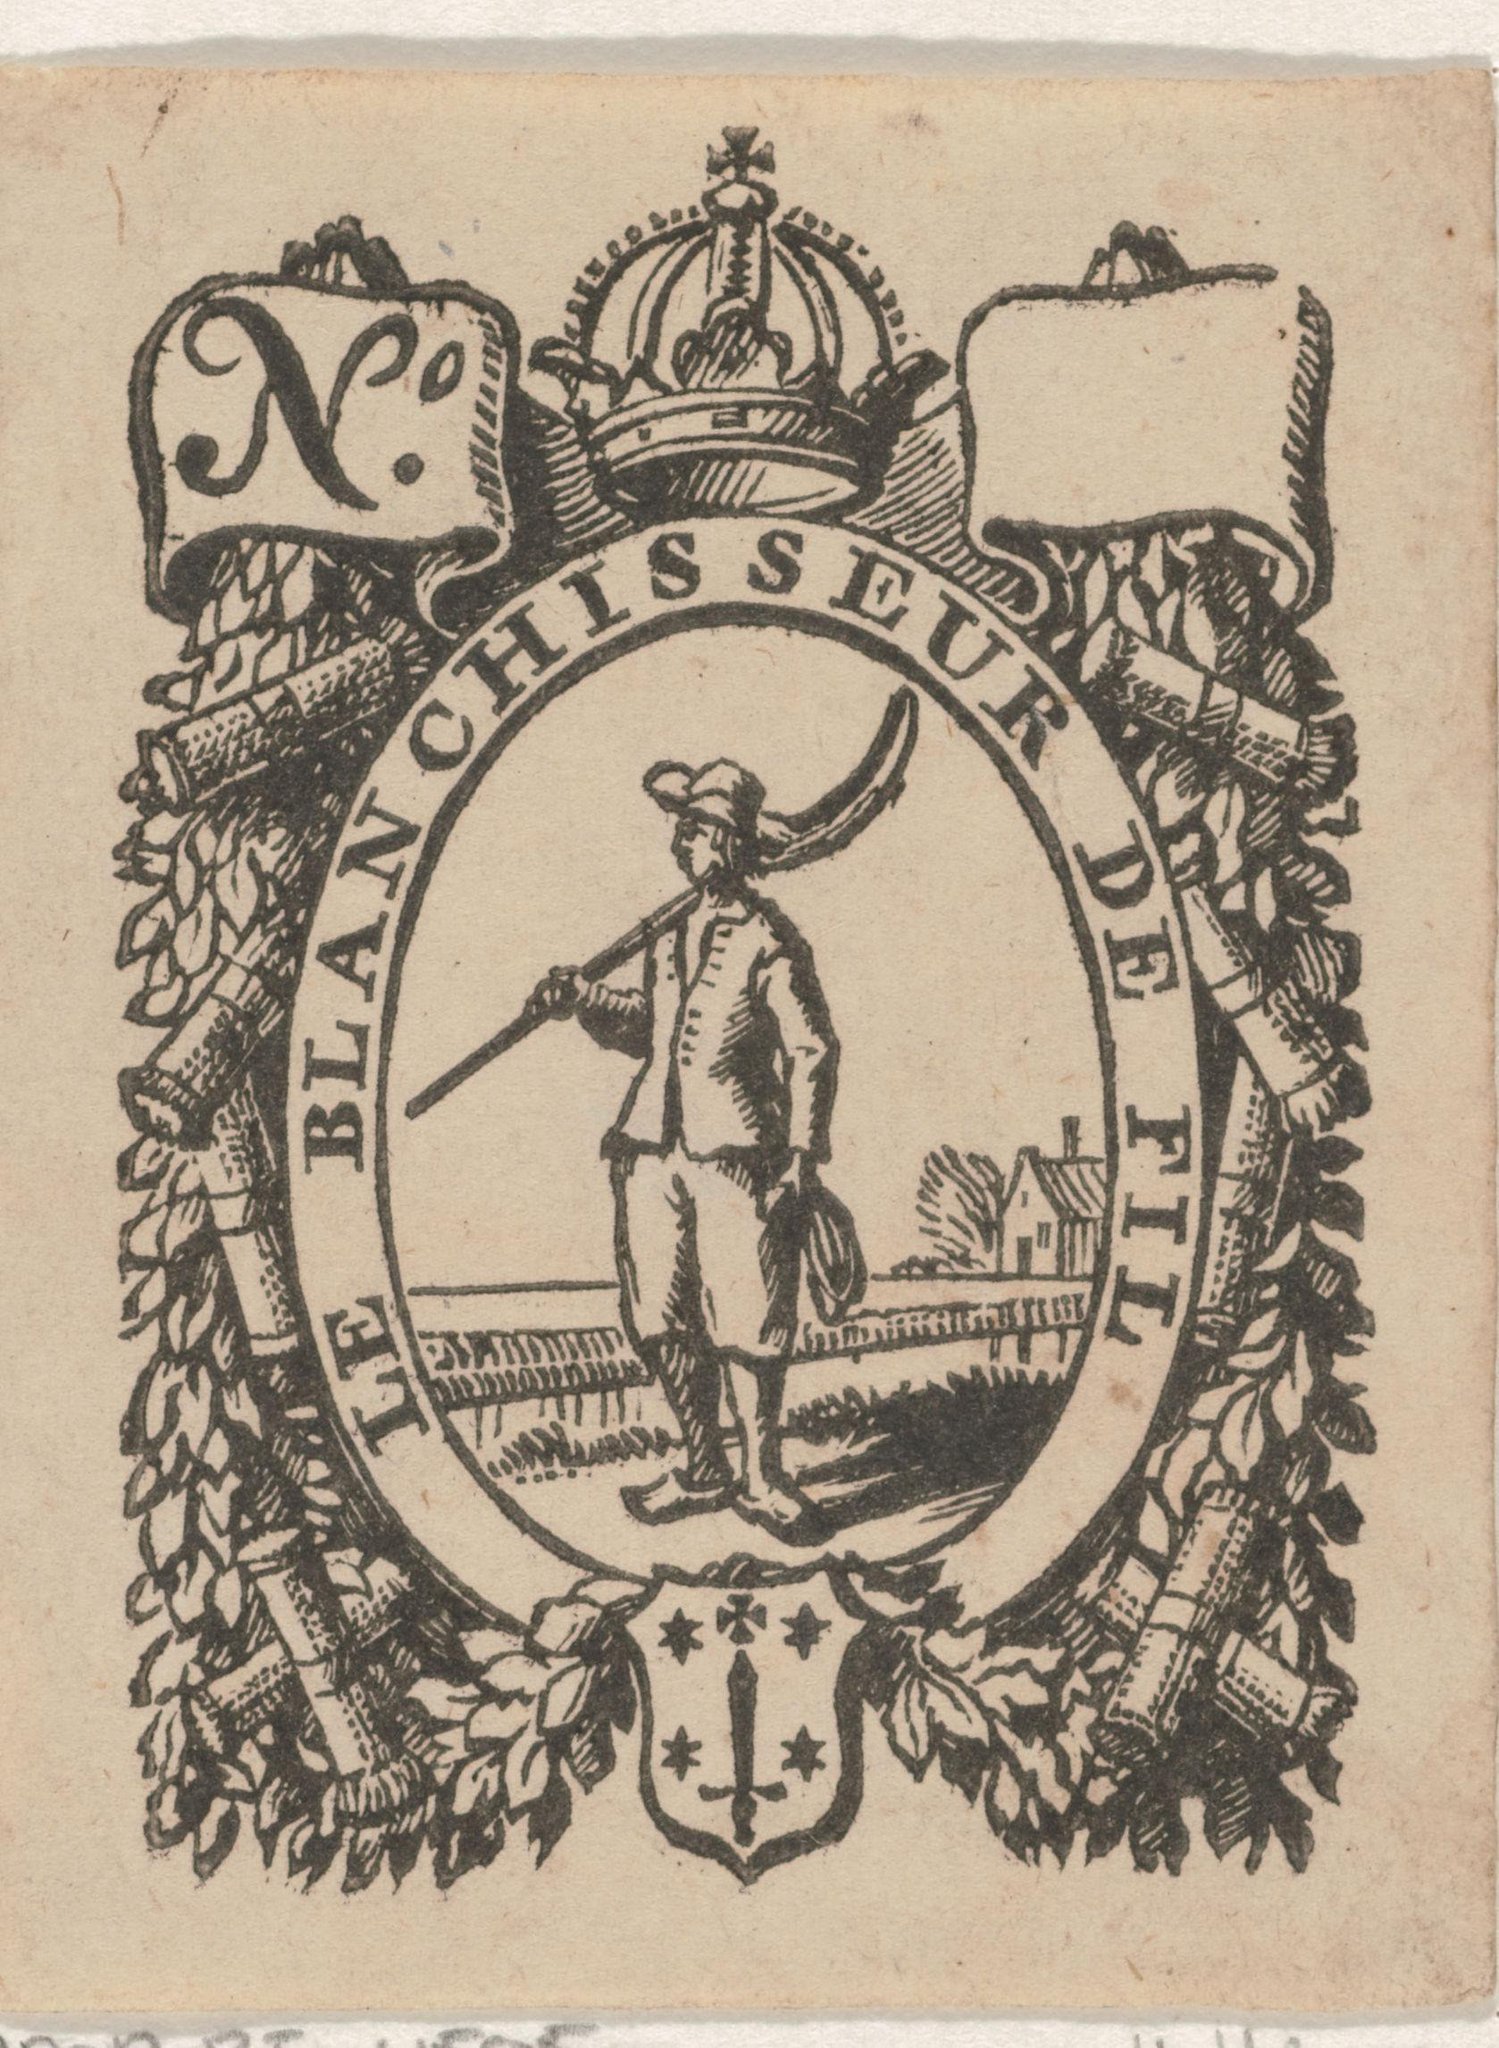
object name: print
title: Handelsetiket met een figuur bij een bleekveld, een kroon en het wapen van de stad Haarlem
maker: isaac vincentsz. van der vinne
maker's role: draughtsman, print maker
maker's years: 1665-1740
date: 1681-1740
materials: paper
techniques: woodcut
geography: haarlem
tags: coat of arms (as symbol of the state, etc.) (+ city; municipal), crown (symbol of sovereignty), bleaching (laundering), vignette, haarlem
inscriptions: collector's mark: Lugt 240